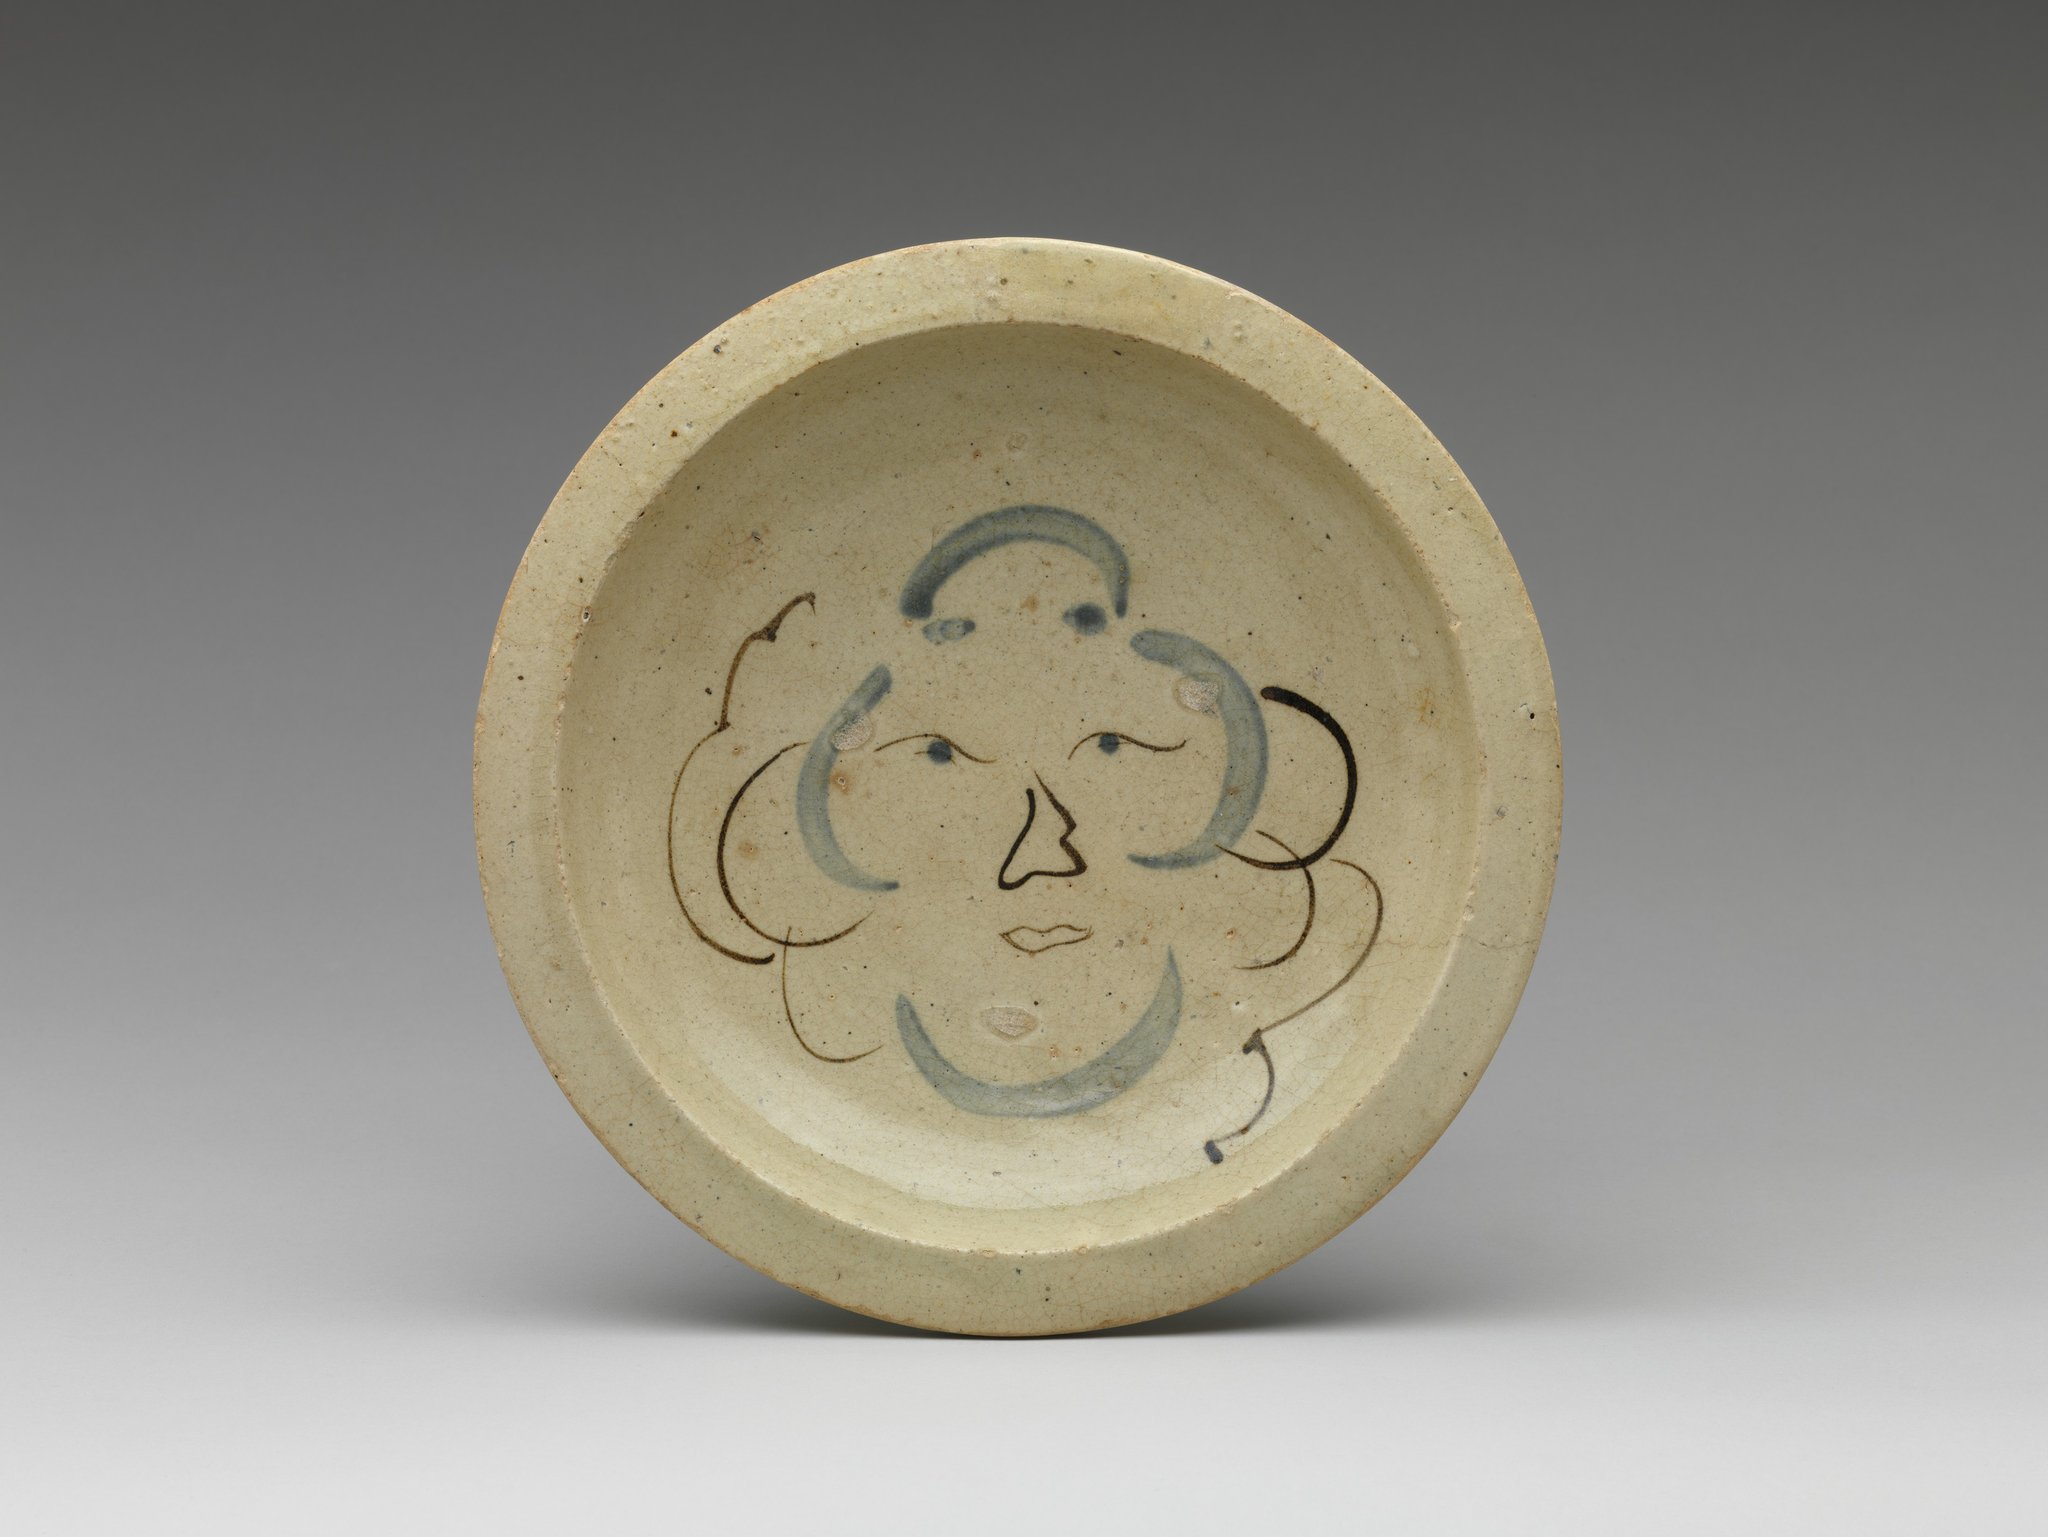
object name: plate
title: Ishizara Plate with Design of Human Face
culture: japanese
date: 1734-1833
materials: stoneware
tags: faces